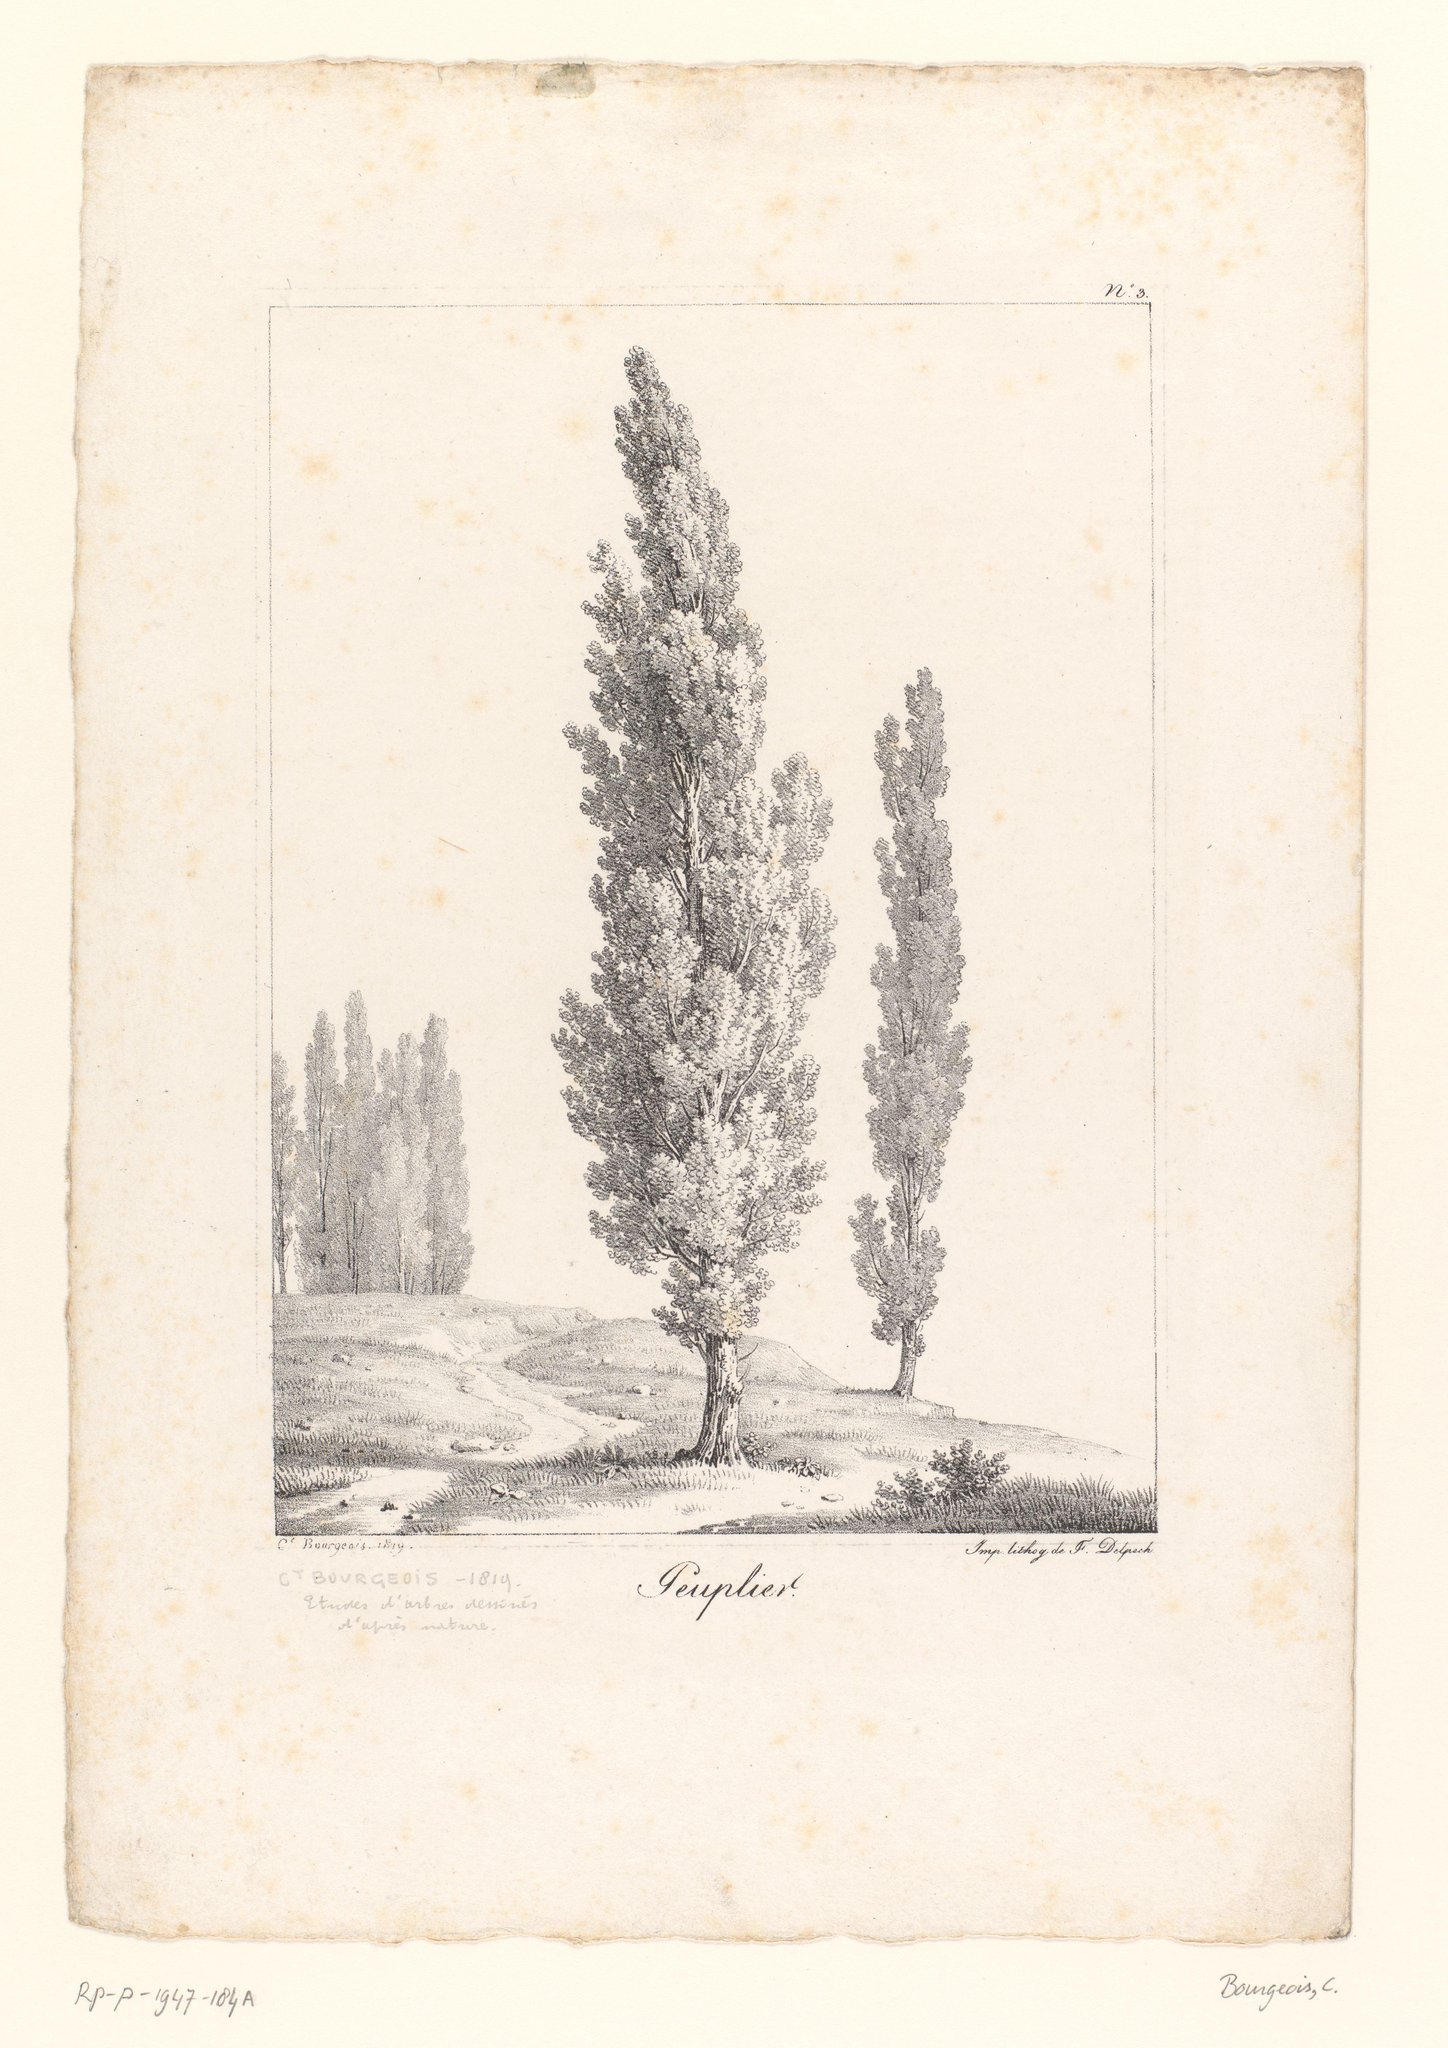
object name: print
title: Populier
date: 1819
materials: paper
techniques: lithograph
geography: paris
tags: trees: poplar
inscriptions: collector's mark: Lugt 2228a